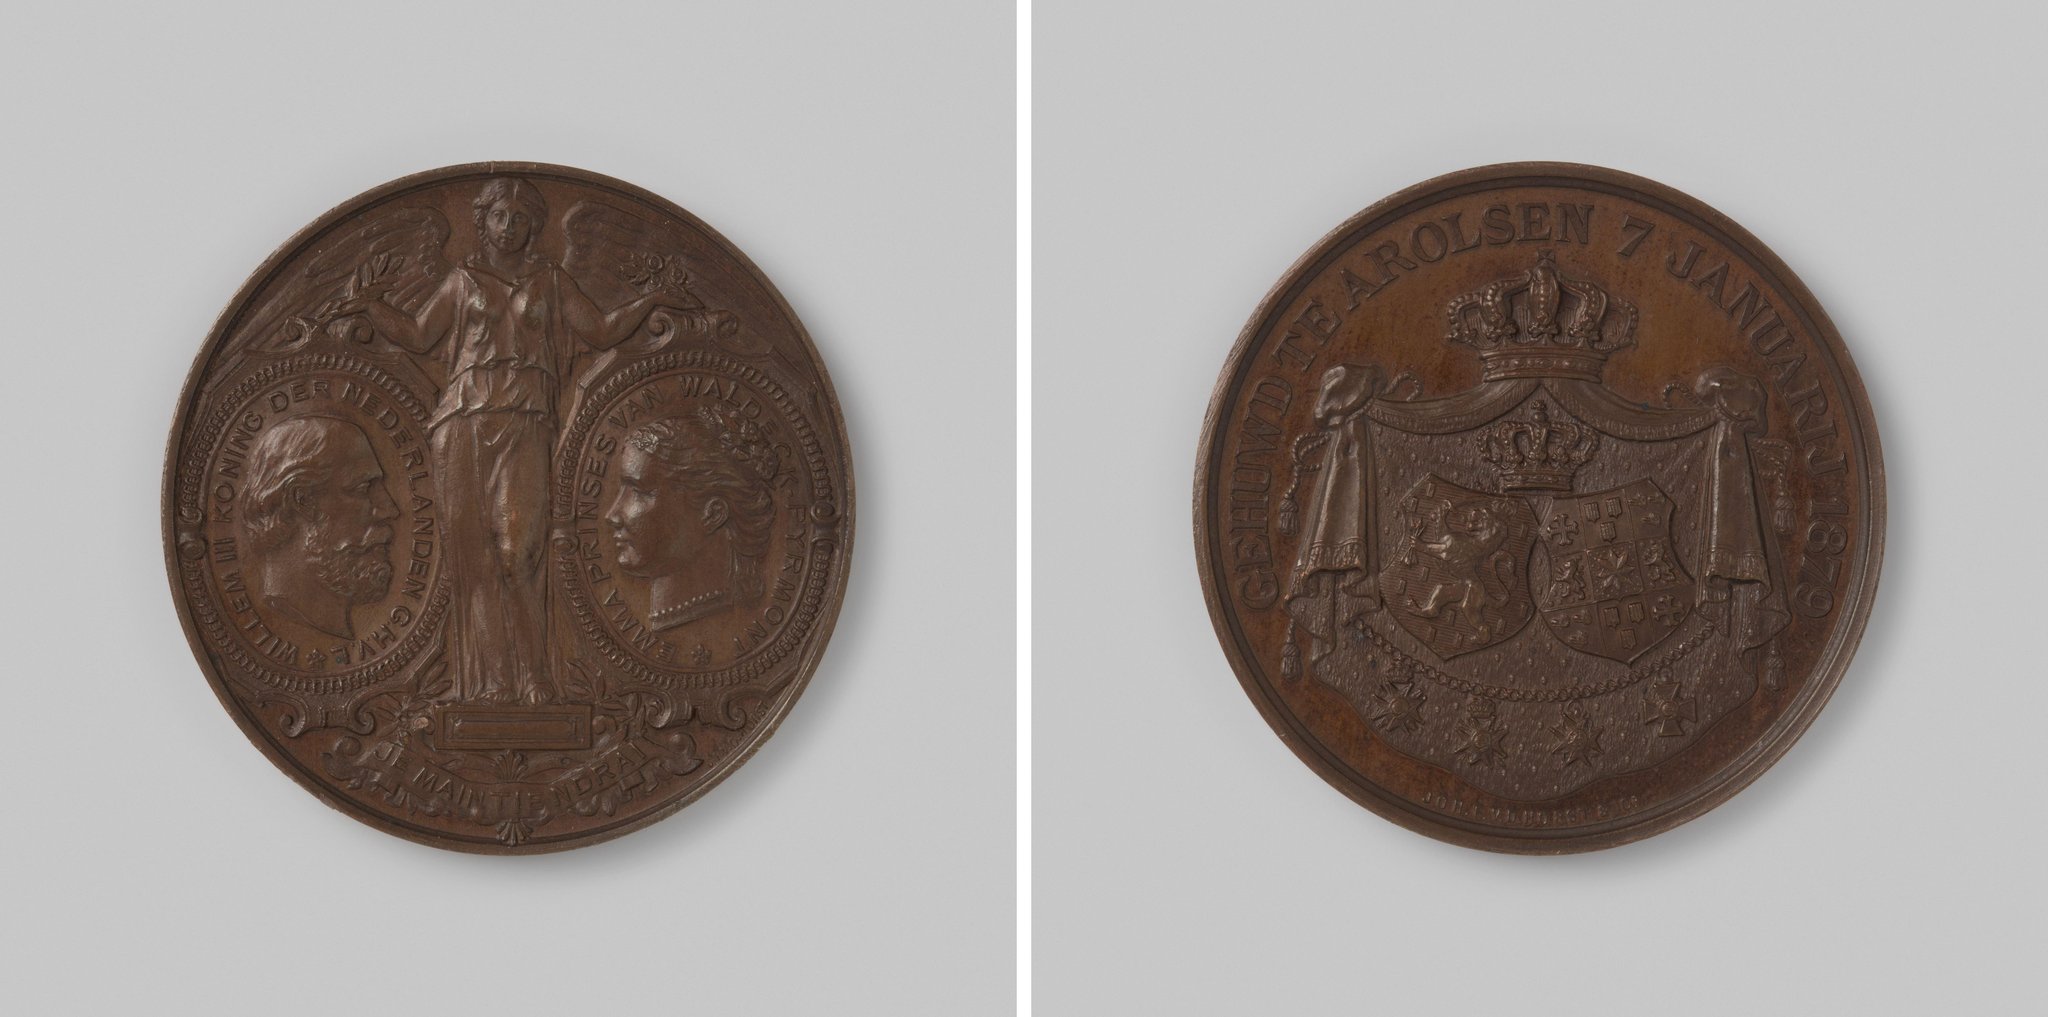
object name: history medal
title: Huwelijk van Koning Willem III met Emma van Waldeck-Pyrmont 1879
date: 1879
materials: bronze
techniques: striking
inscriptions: hallmark: ‘CUIVRE en symbool’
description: Bronzen penning, op de voorzijde een aanziende gevleugelde genius een op voetstuk met tekstlint, met ovalen medaillons waarin de portretten van Willem III en Emma, elk met omschrift, op de keerzijde een gekroonde mantel waarop onder één kroon de wapenschilden van Nederland en Waldeck-Pyrmont en een keten met vier ordetekenen, met bovenaan omschrift.